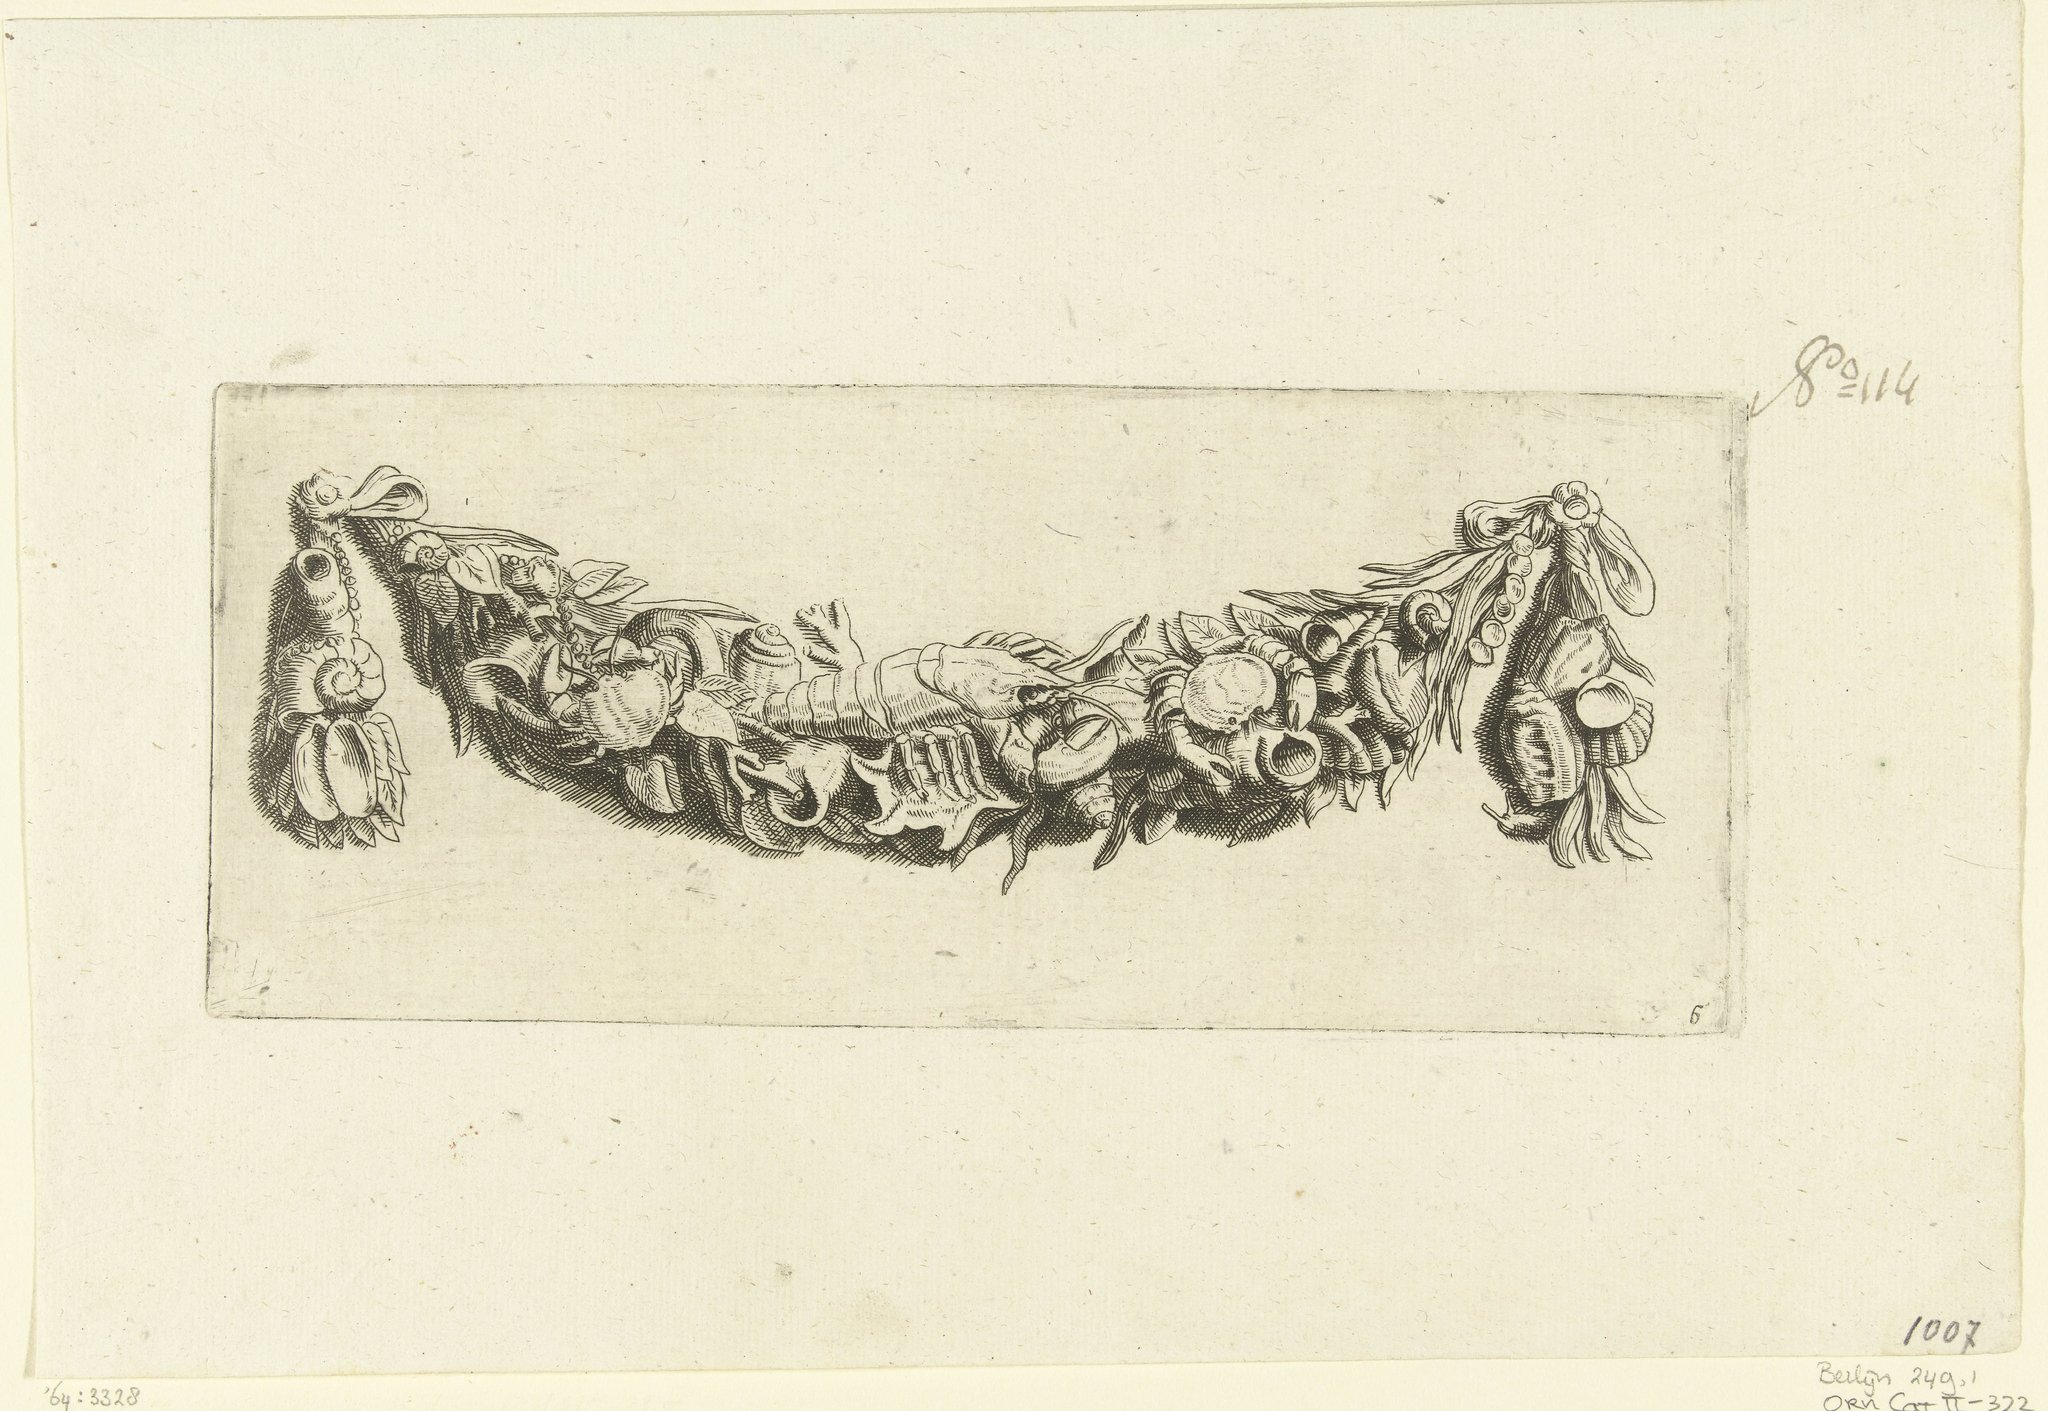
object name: print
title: Festoen van schelpen en zeedieren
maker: Anonymous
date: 1665-1700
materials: paper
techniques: etching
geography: amsterdam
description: Kopie naar festoen uit de serie Prima Pars Praecipuarum.../ Het Eerste Deel Van de voornaemste Statuen ende Cieraten.../ La Premier Partie....